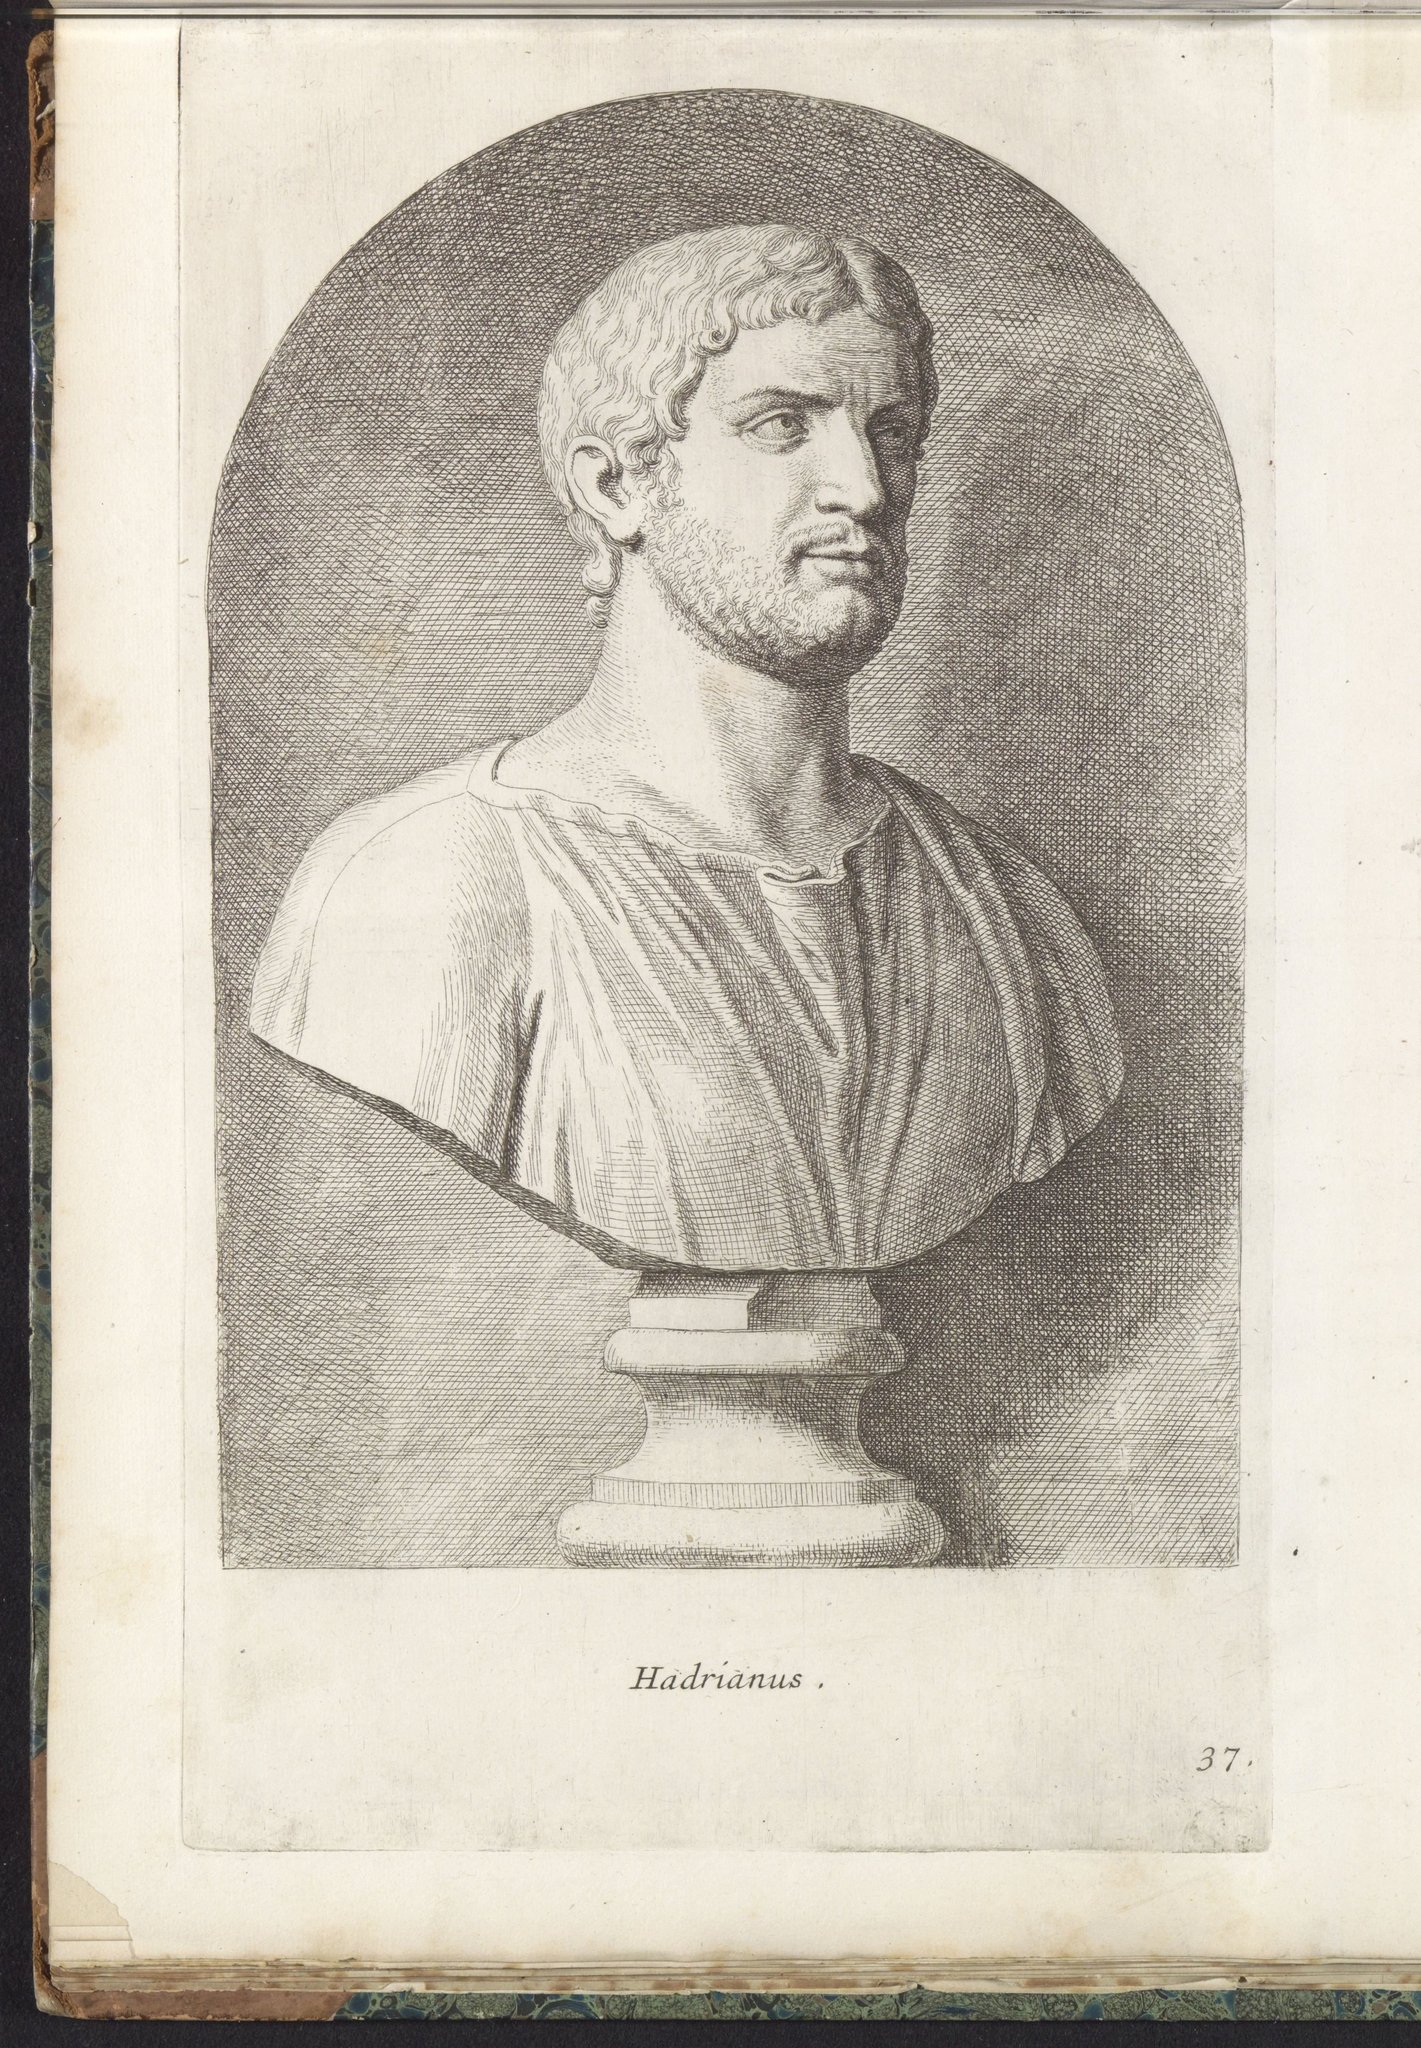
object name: print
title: Octavia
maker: hubert quellinus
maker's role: print maker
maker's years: 1619-1687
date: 1646-1670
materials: paper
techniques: engraving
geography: antwerp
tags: piece of sculpture, reproduction of a piece of sculpture, male persons from classical history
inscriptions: number: ‘58’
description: Klassieke buste van een bebaarde man in een hemd. De prent maakt deel uit van een album met een serie prenten naar de sculpturen in de verzameling van Gerard Reynst.